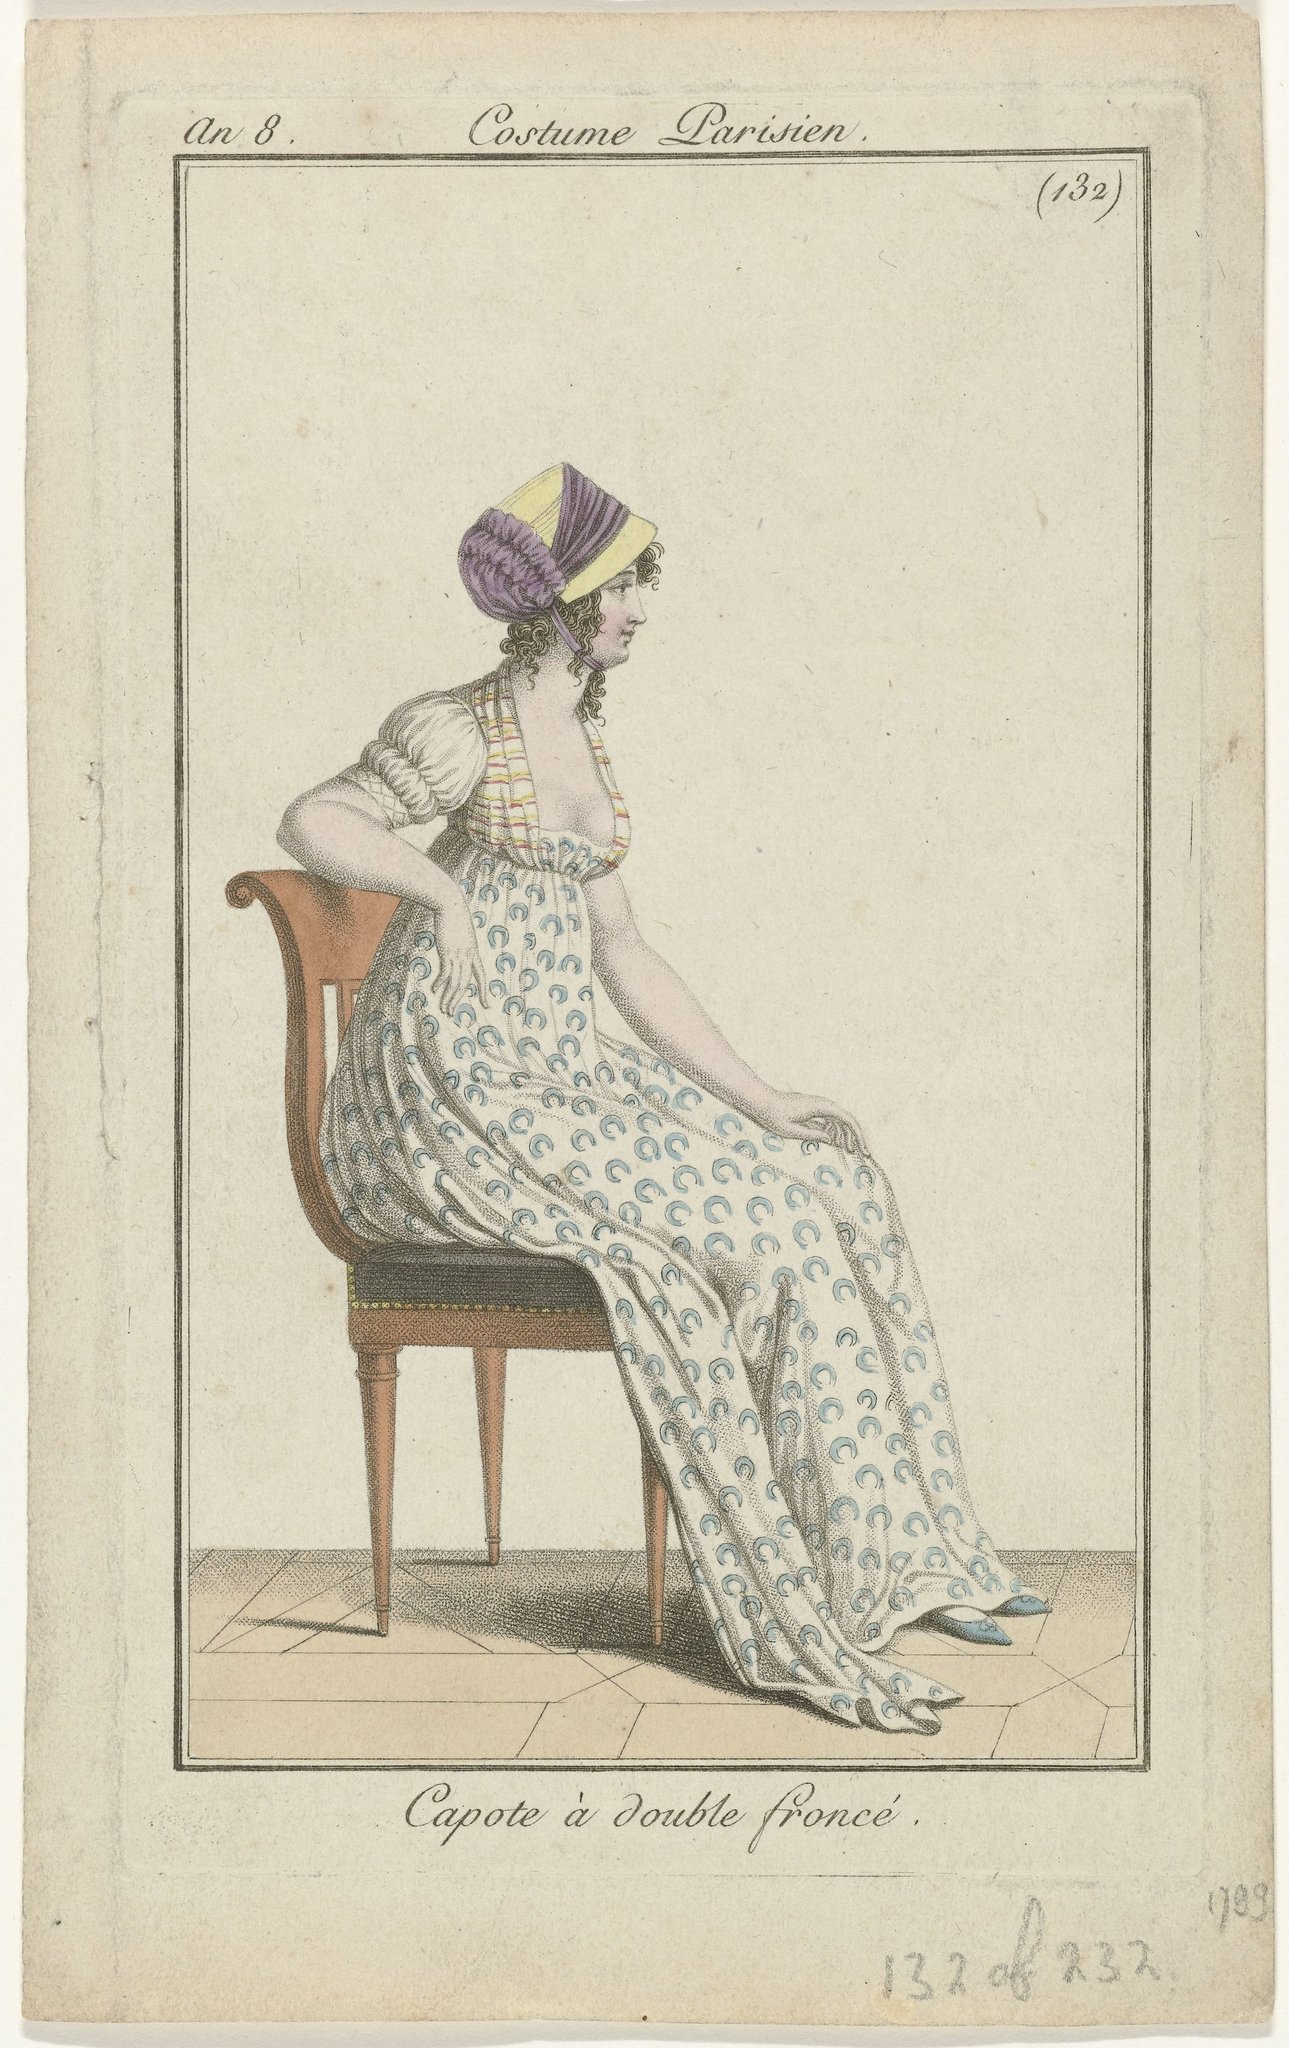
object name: fashion print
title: Journal des Dames et des Modes, Costume Parisien, 24 juillet 1800, An 8, (132) of (232) : Capote à double froncé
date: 1800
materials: paper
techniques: engraving, hand coloring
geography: paris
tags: head-gear (capote) (+ women's clothes), fashion plates, shoes, sandals (+ women's clothes), dress, gown (+ women's clothes), chair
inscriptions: caption: ‘Capote à double froncé.’, title: ‘Costume Parisien.’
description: Vrouw, zittend op een stoel, op het hoofd een 'capote' versierd met smokwerk. Zij draagt een japon met een patroon van boogjes. Pofmouwen en sleep. Om de hals een gestreepte fichu (?). platte schoenen met puntige neuzen. De prent maakt deel uit van het modetijdschrift Journal des Dames et des Modes, uitgegeven door Pierre de la Mésangère, Parijs, 1797-1839.